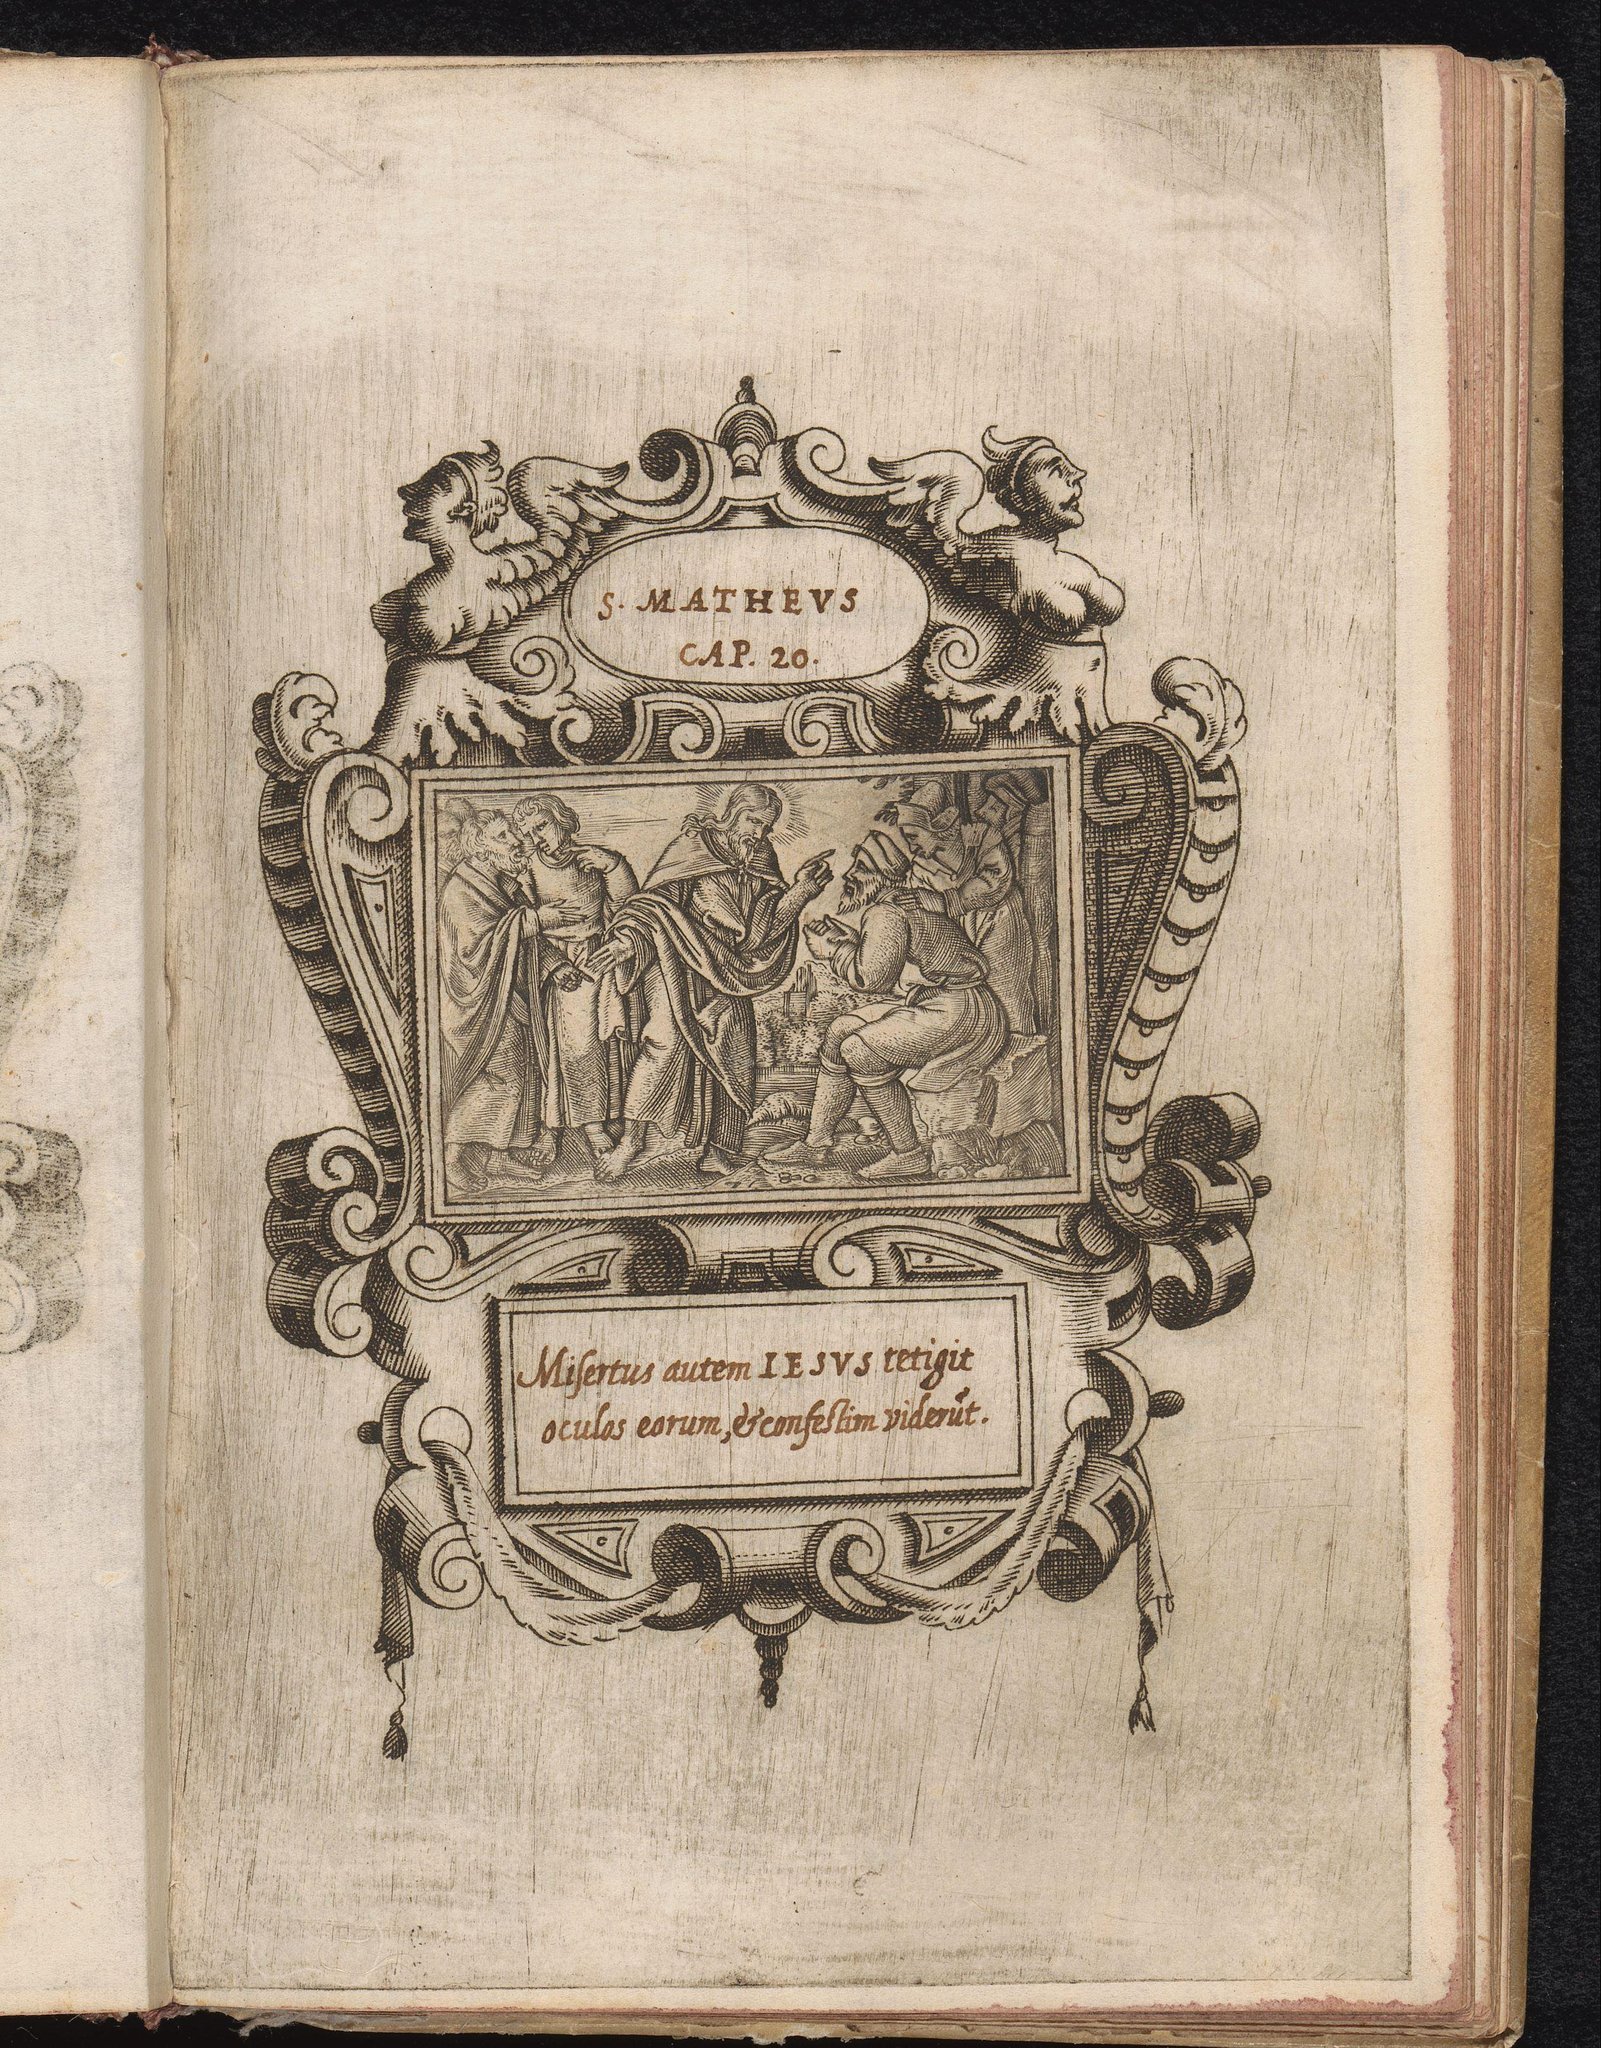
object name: print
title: Genezing van twee blinden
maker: Anonymous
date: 1570-1610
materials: paper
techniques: engraving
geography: germany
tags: healing of two blind men, or one (bartimaeus), sitting near jericho (matthew 20:29-34; mark 10:46-52; luke 18:35-43)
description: Genezing van twee blinden voor de stadspoort van Jericho. Onderdeel van een prentalbum met titelprent en 56 scènes uit het Nieuwe Testament. Elke voorstelling gemonteerd in een gravure met ornamentele cartouches waarin een venster is gesneden en voorzien van handgeschreven bijbelpassages.